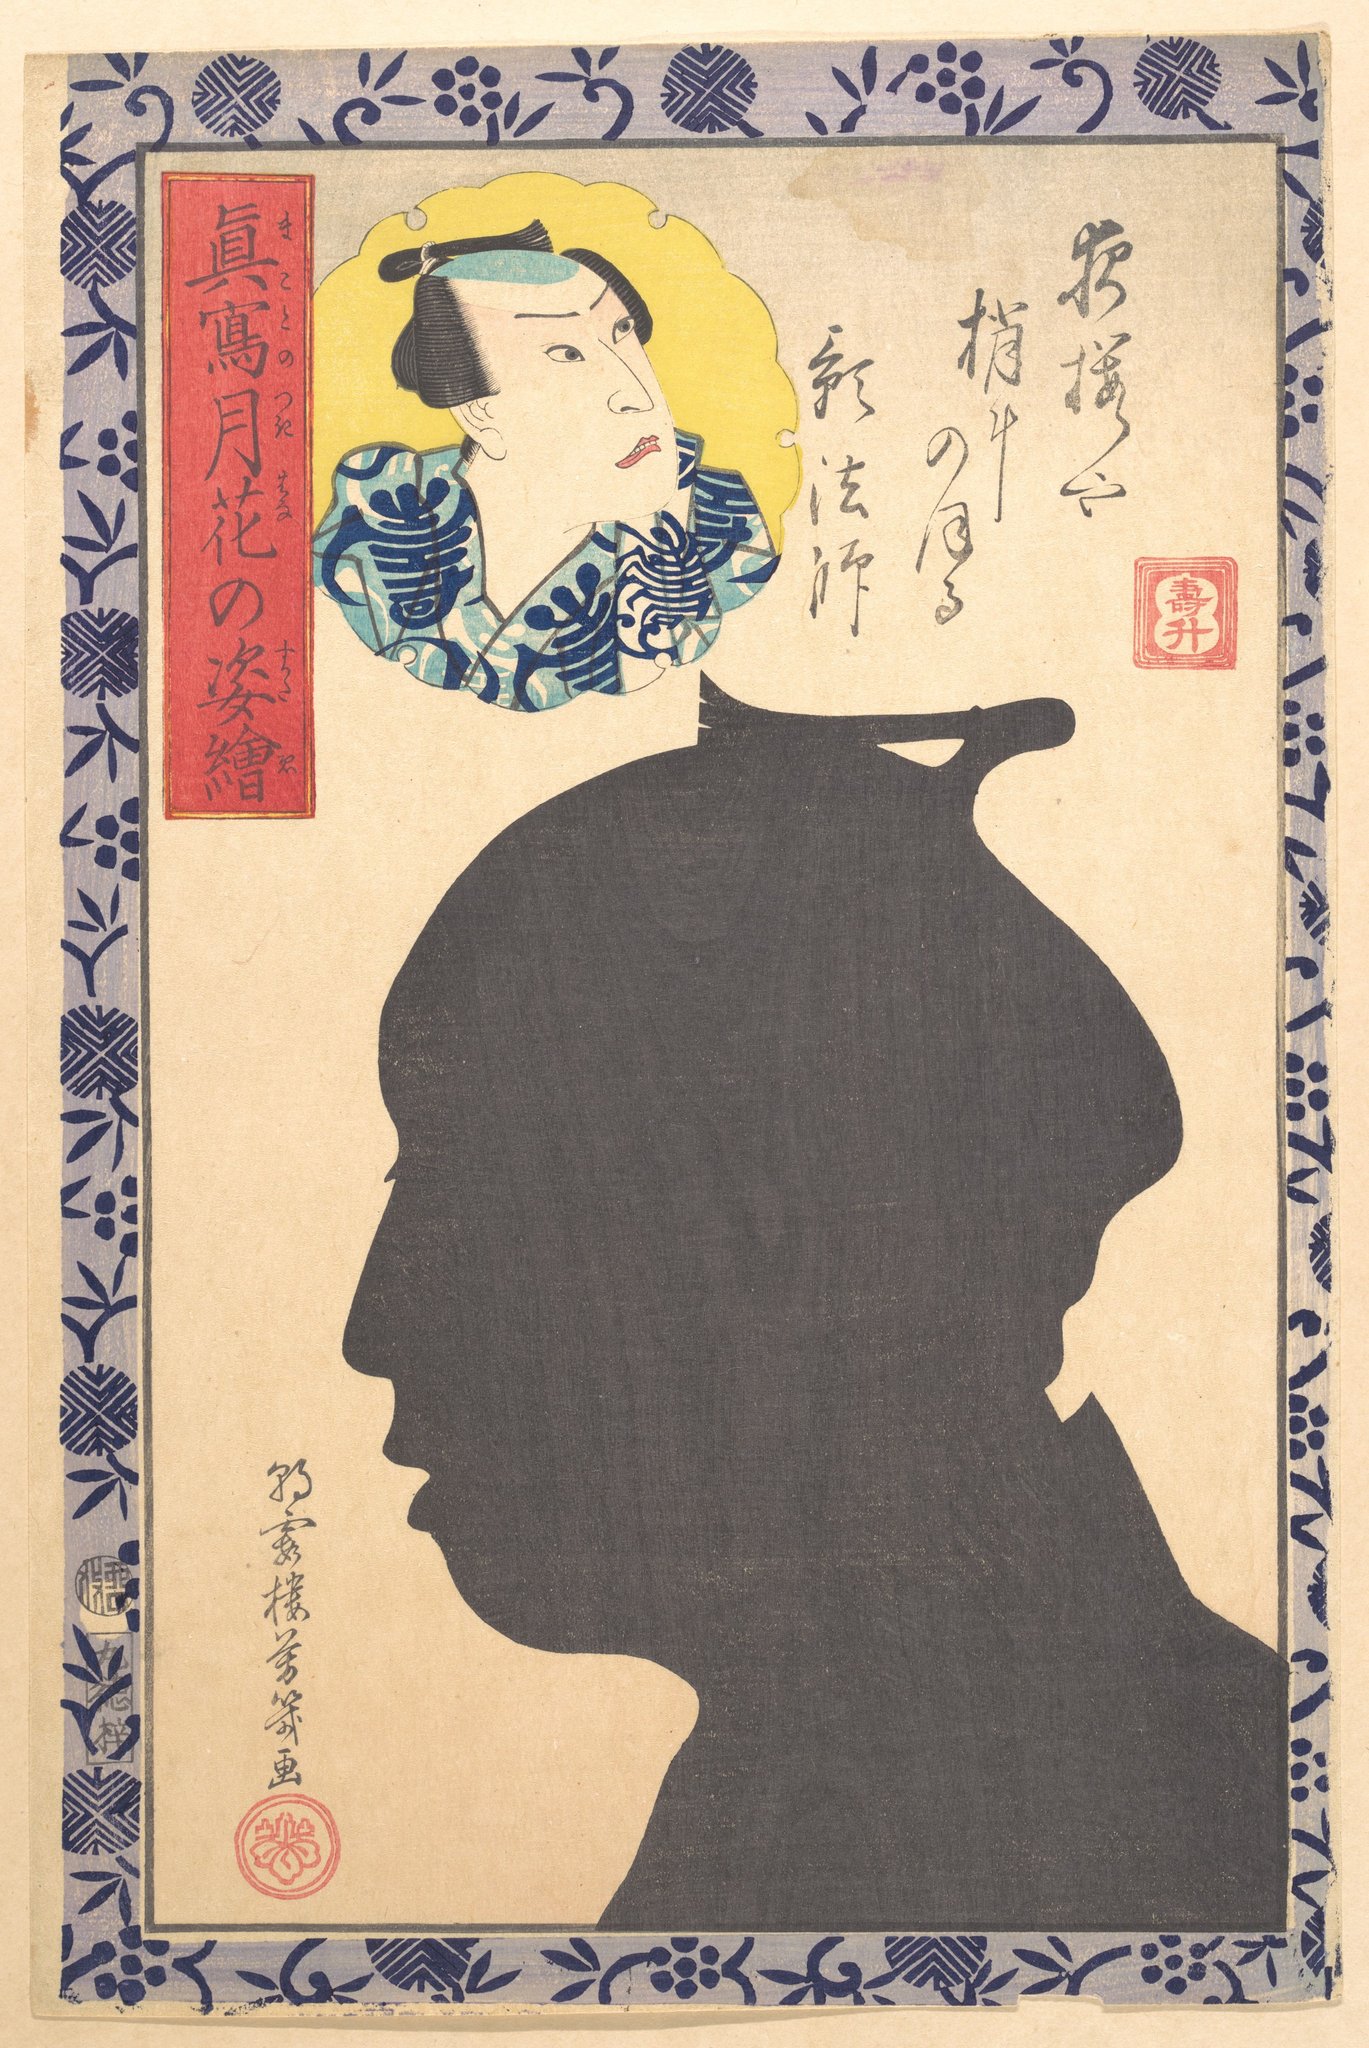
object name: print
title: Silhouette Image of Kabuki Actor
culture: japanese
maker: utagawa yoshiiku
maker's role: artist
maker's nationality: japanese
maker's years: 1833-1904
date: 1801-1900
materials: ink, paper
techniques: woodblock print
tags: men,profiles,actors